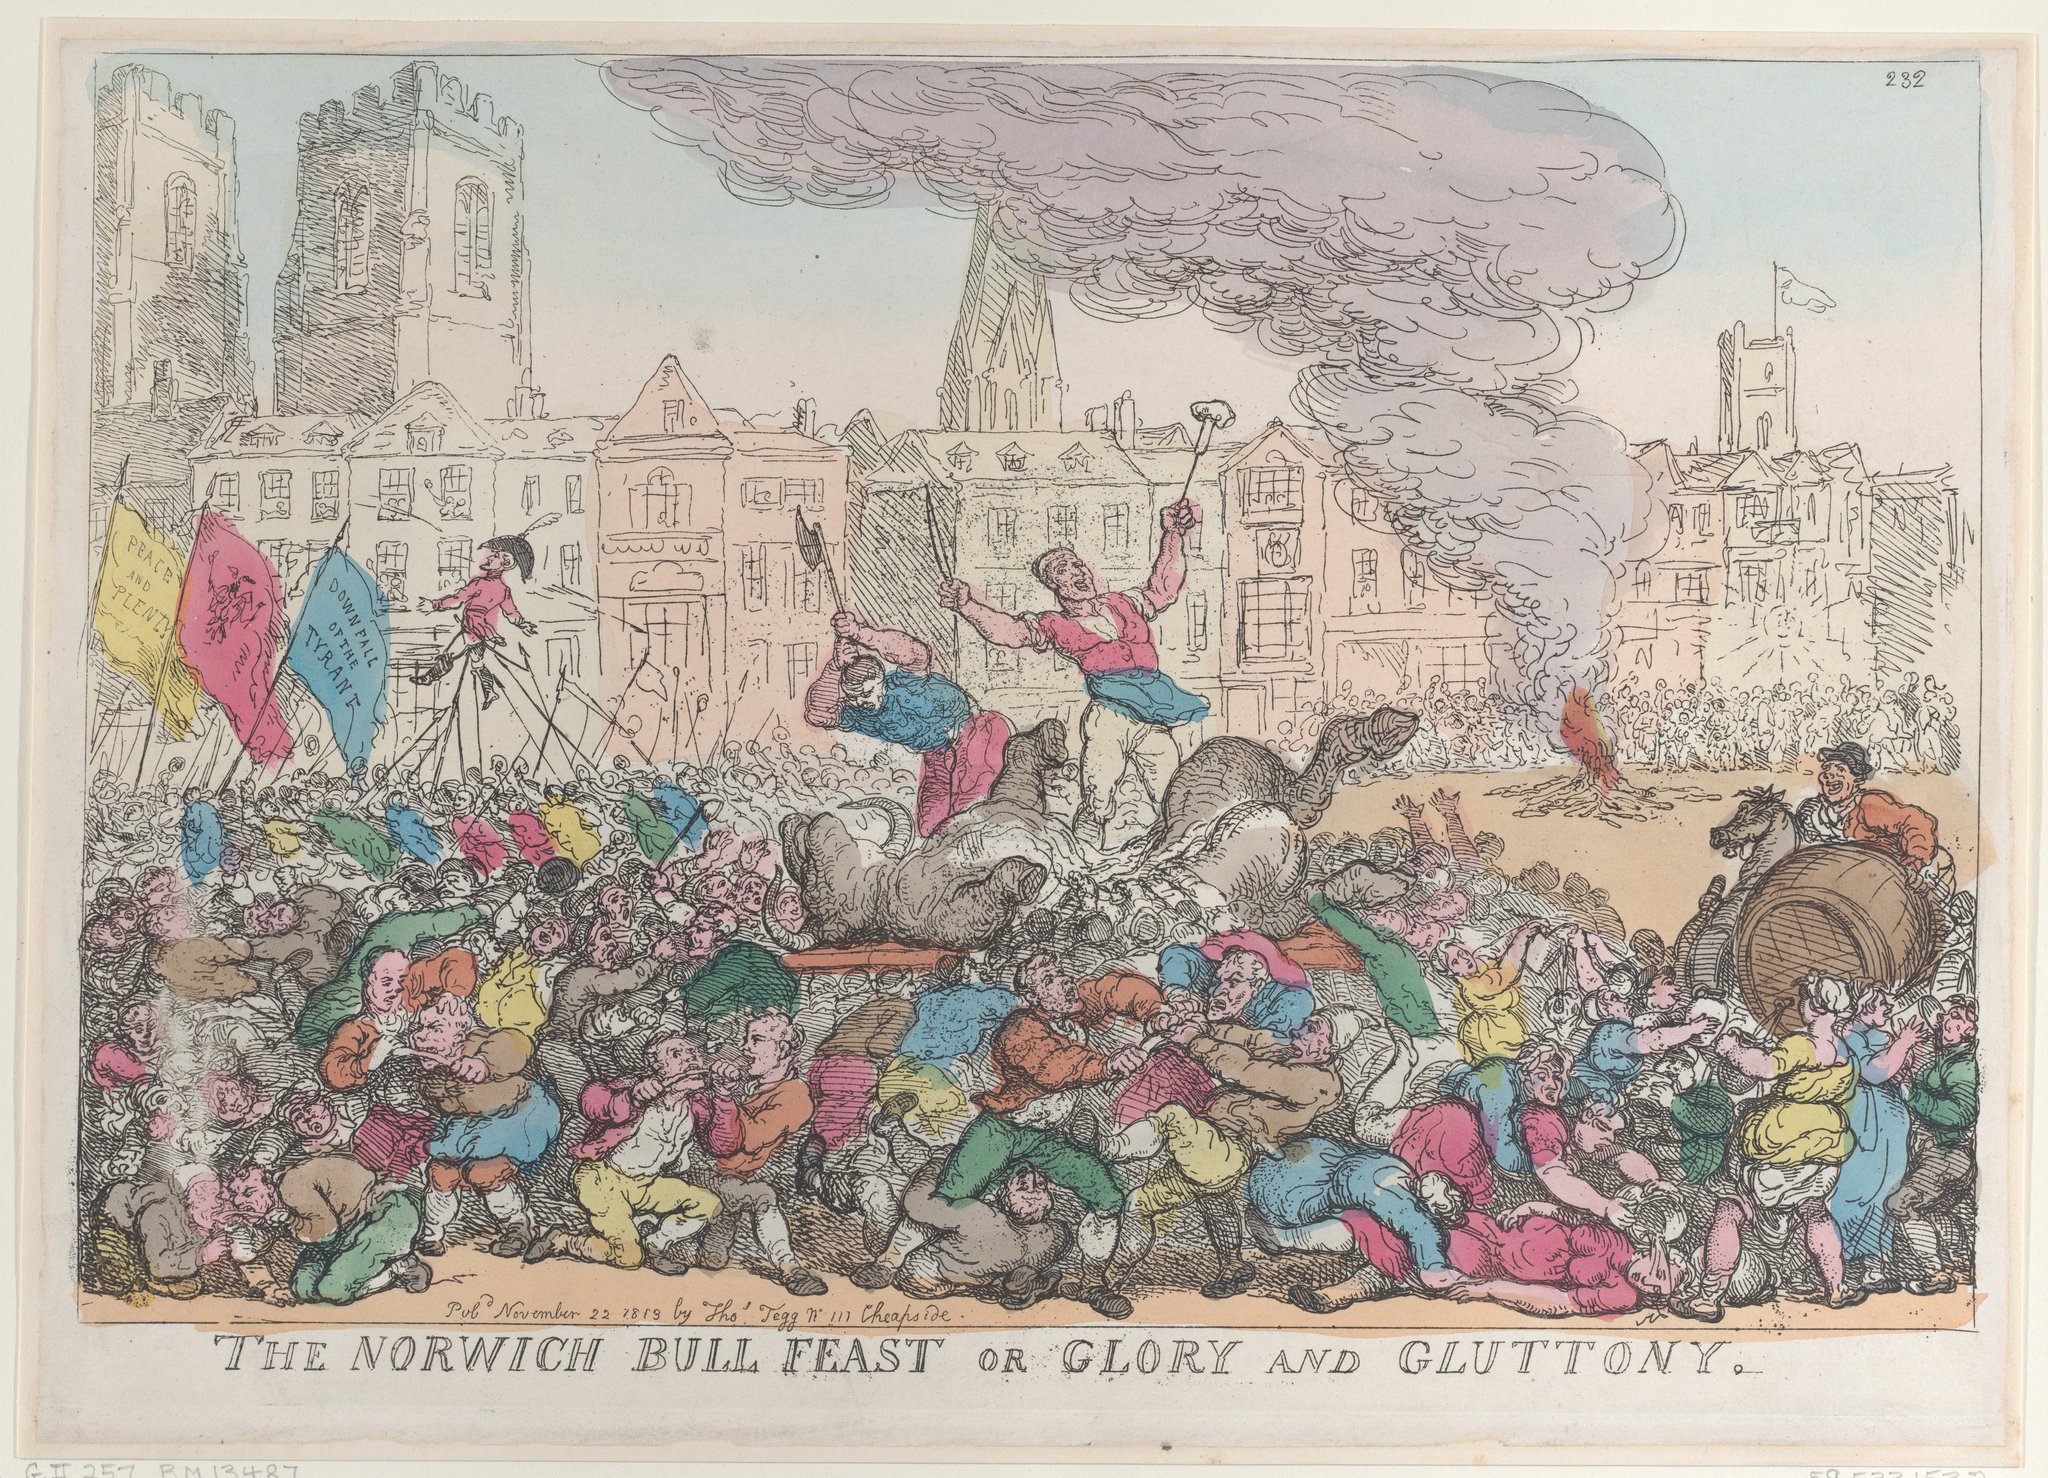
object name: print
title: The Norwich Bull Feast or Glory and Gluttony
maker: thomas rowlandson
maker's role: artist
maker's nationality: british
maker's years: 1757-1827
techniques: etching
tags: satire,crowd